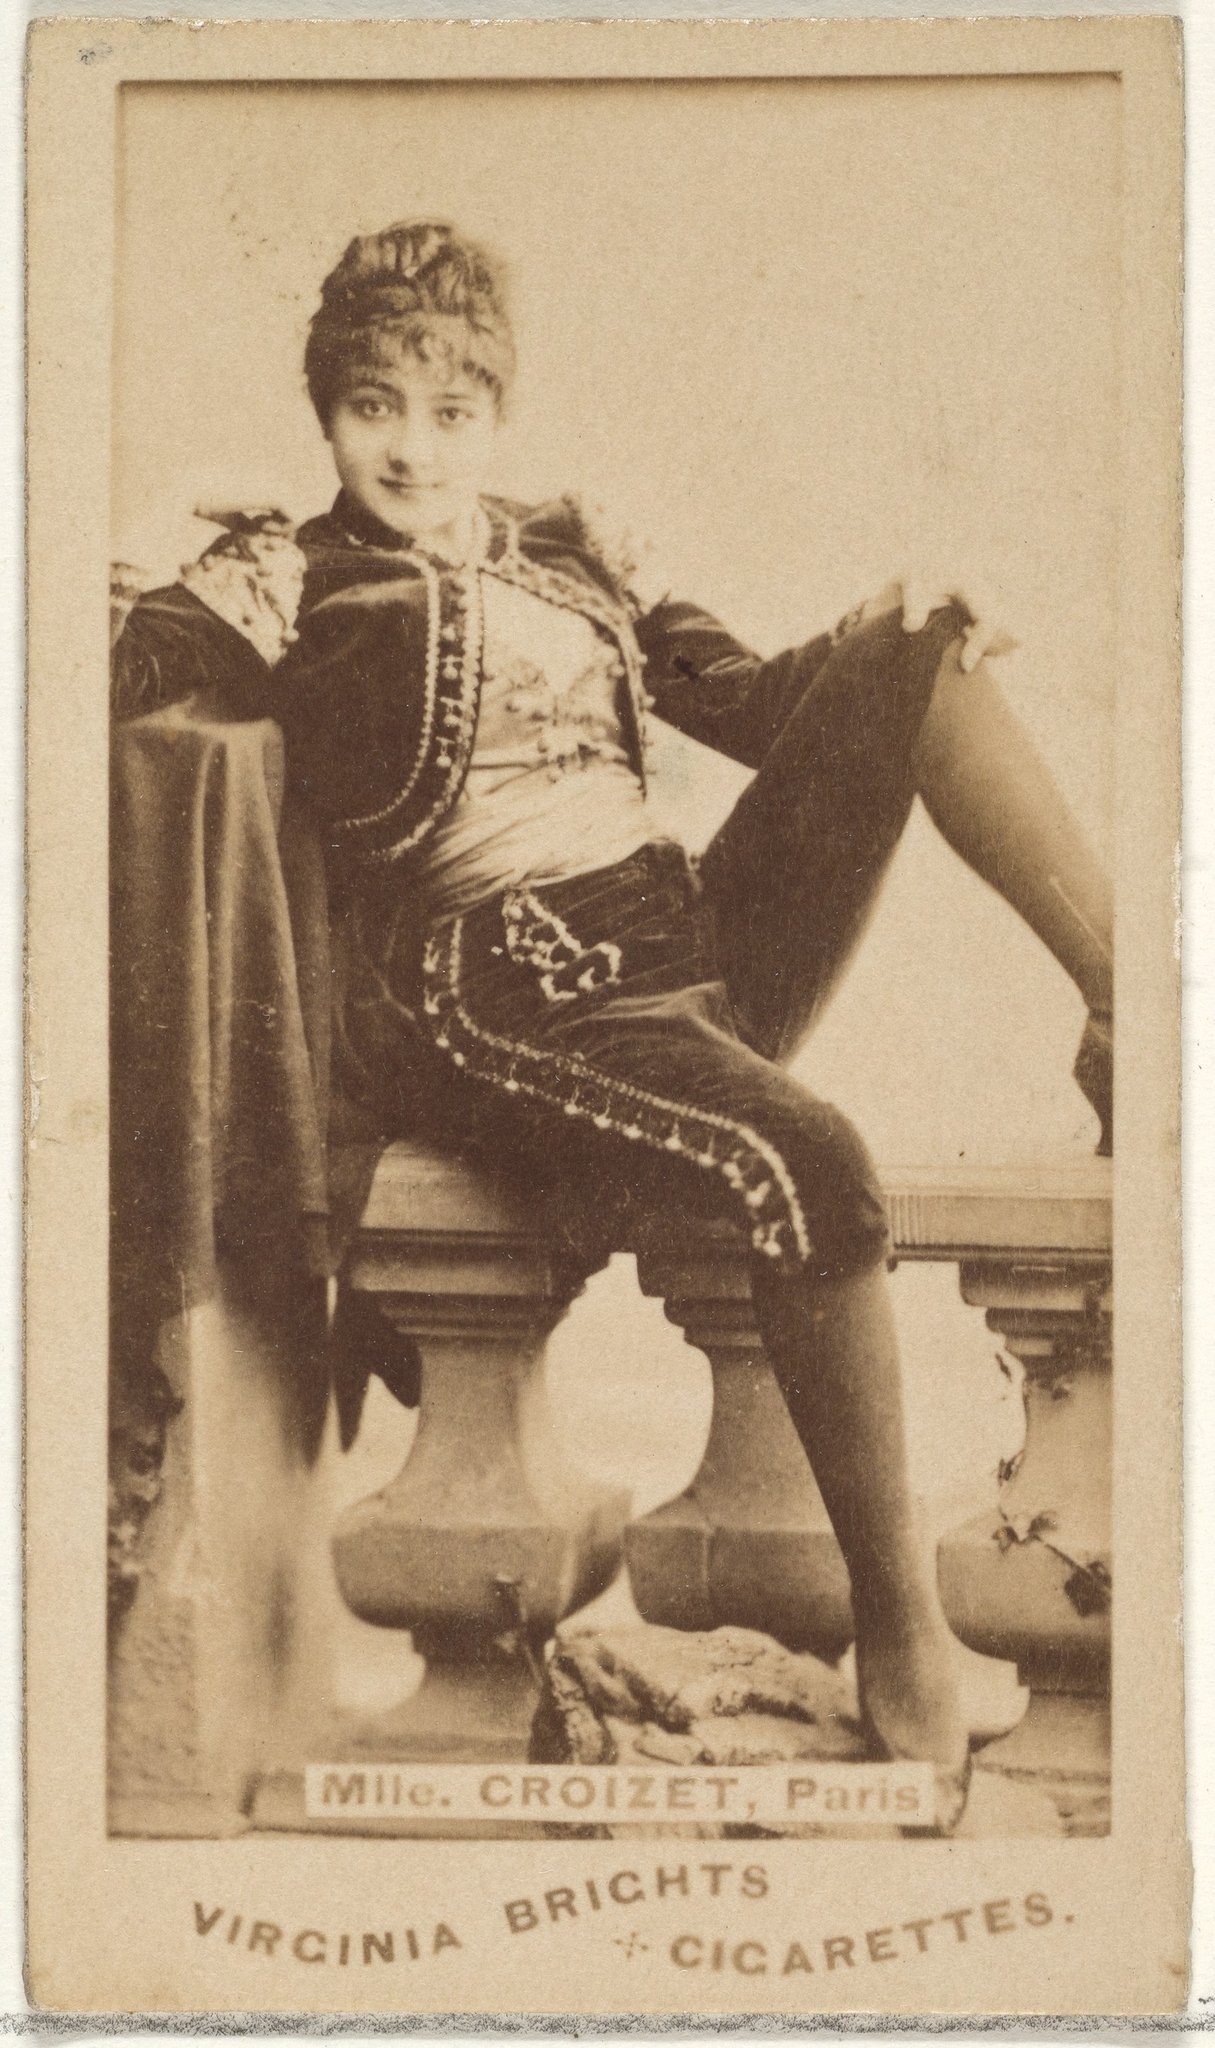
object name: photograph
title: Mlle. Croizet, Paris, from the Actors and Actresses series (N45, Type 1) for Virginia Brights Cigarettes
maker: allen & ginter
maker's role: publisher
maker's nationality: american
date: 1888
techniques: albumen silver print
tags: portraits,women,actresses